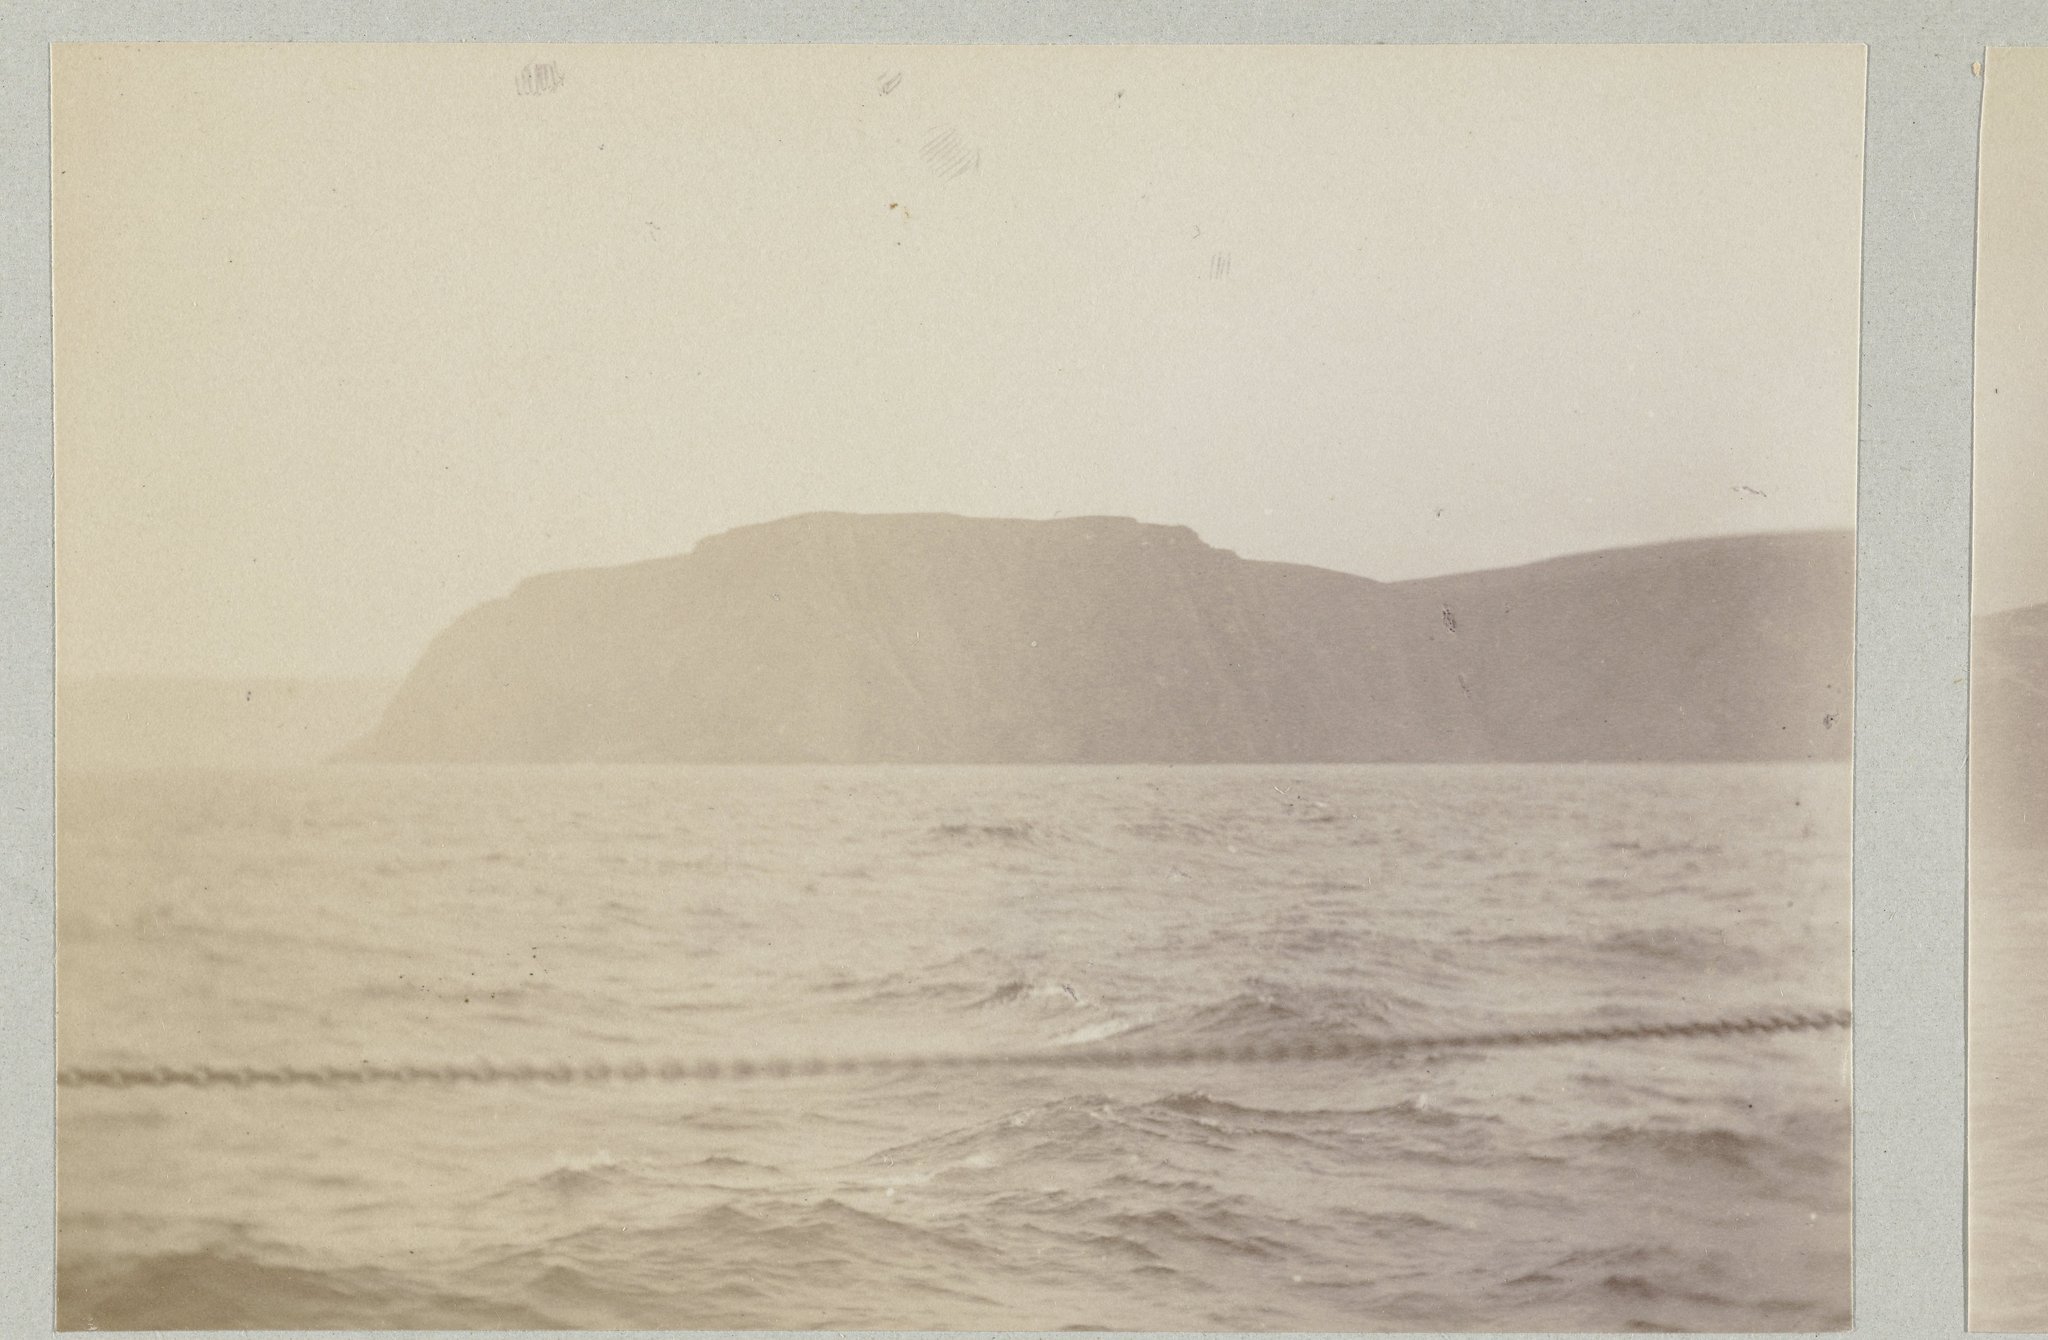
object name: photograph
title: Zicht over zee vanaf een schip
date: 1807-1889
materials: cardboard, paper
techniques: albumen print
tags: wilhelm ii (keizer van duitsland), norway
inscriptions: number: ‘28’